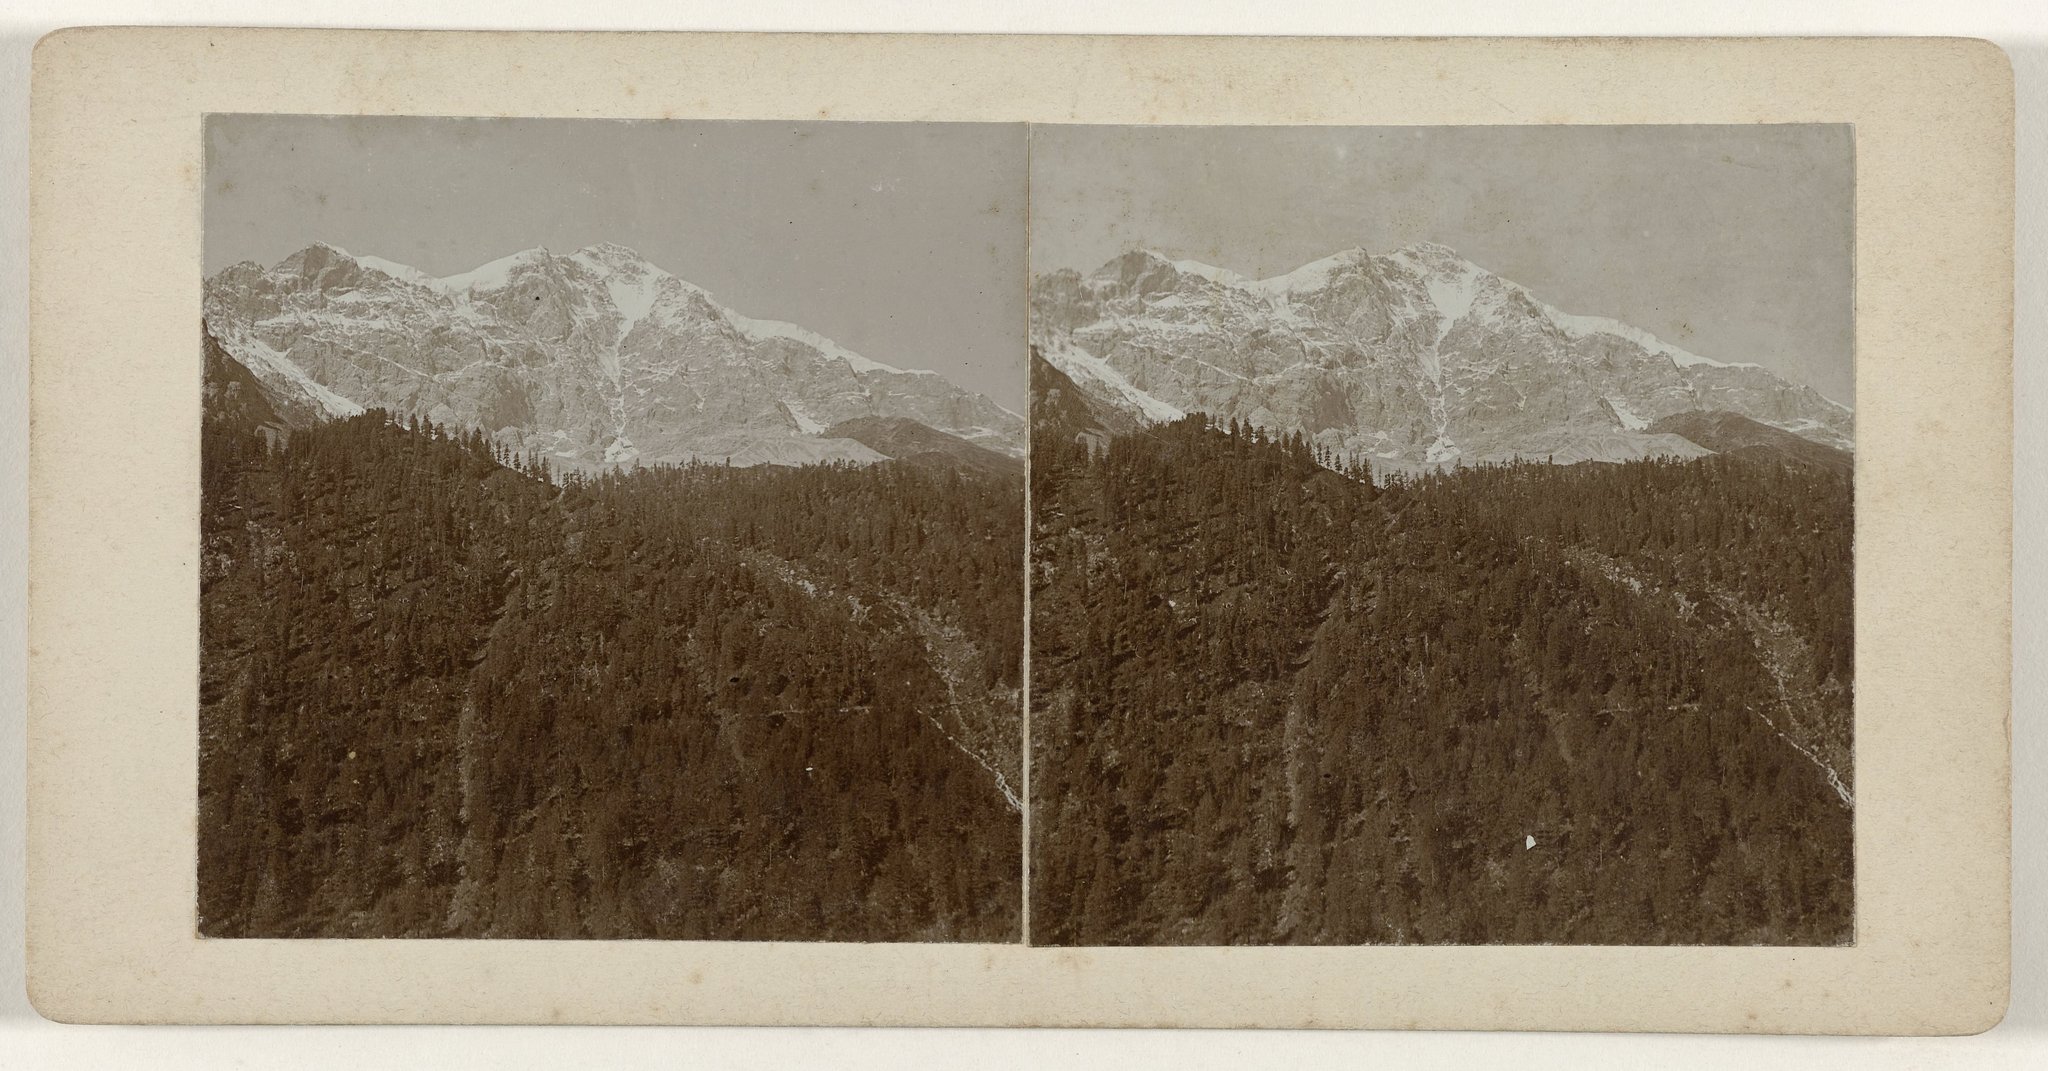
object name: stereograph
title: Gezicht op berglandschap gezien vanuit een bosrijke omgeving, Oostenrijk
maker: geldolph adriaan kessler (dolph)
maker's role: fotograaf, industrieel, voetballer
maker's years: 1884-1945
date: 1906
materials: paper, photographic support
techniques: collodion silver print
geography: austria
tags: austria